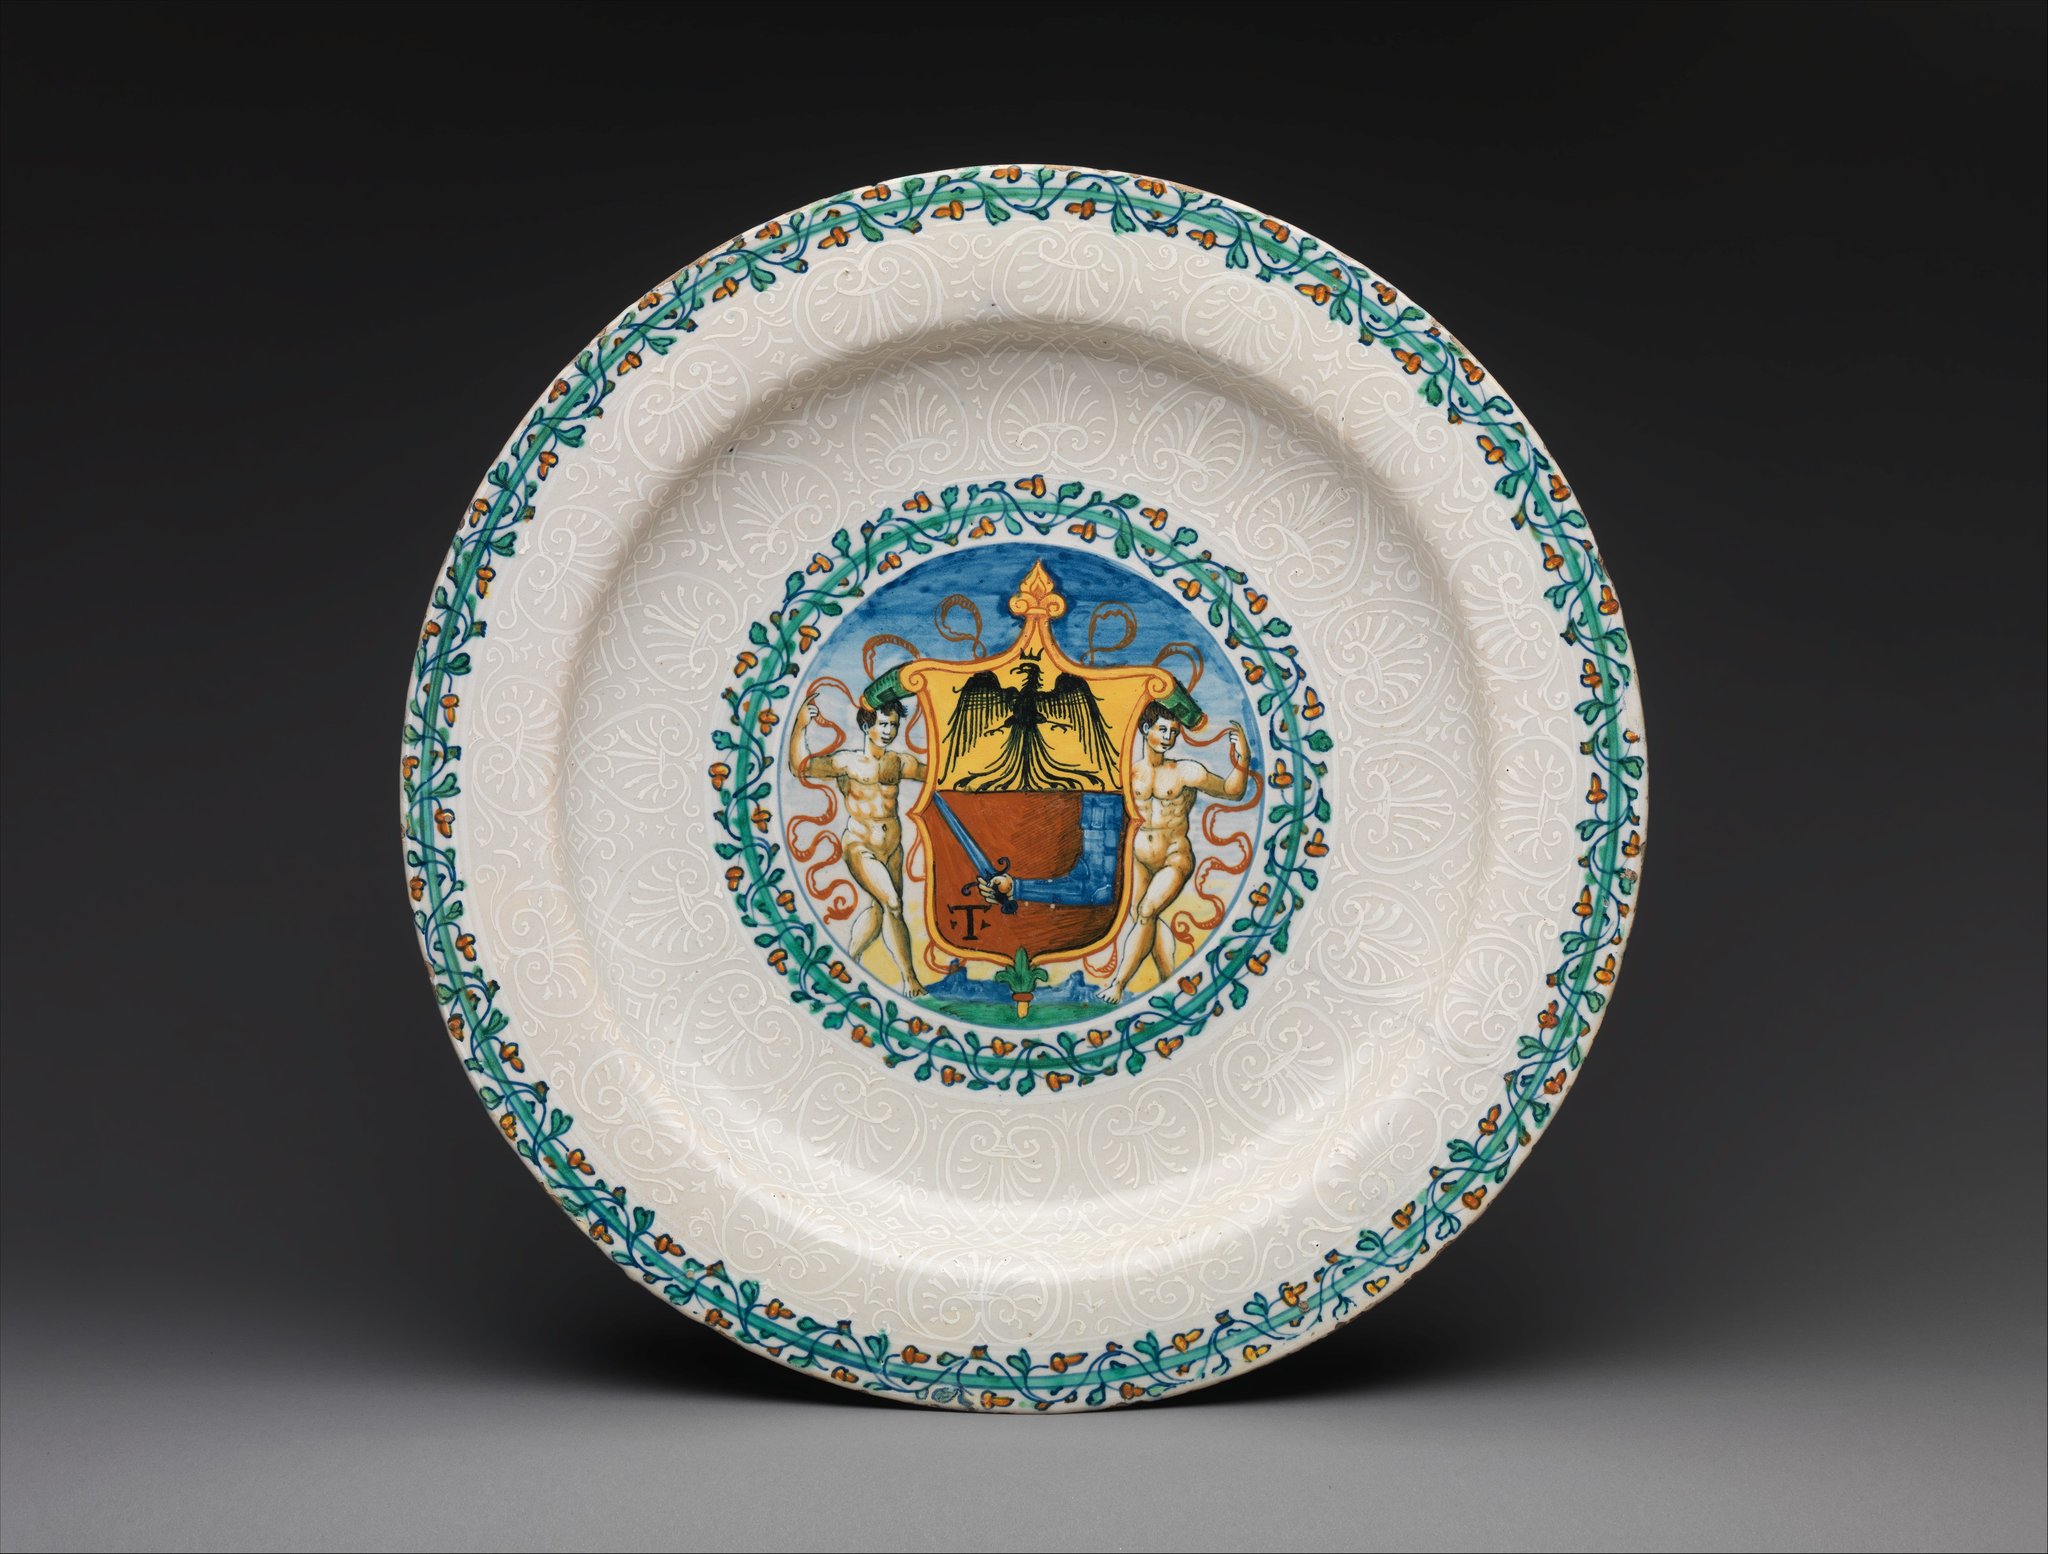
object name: dish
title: Armorial dish with bianco sopra bianco ornament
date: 1545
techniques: maiolica, glazing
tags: eagles,male nudes,coat of arms